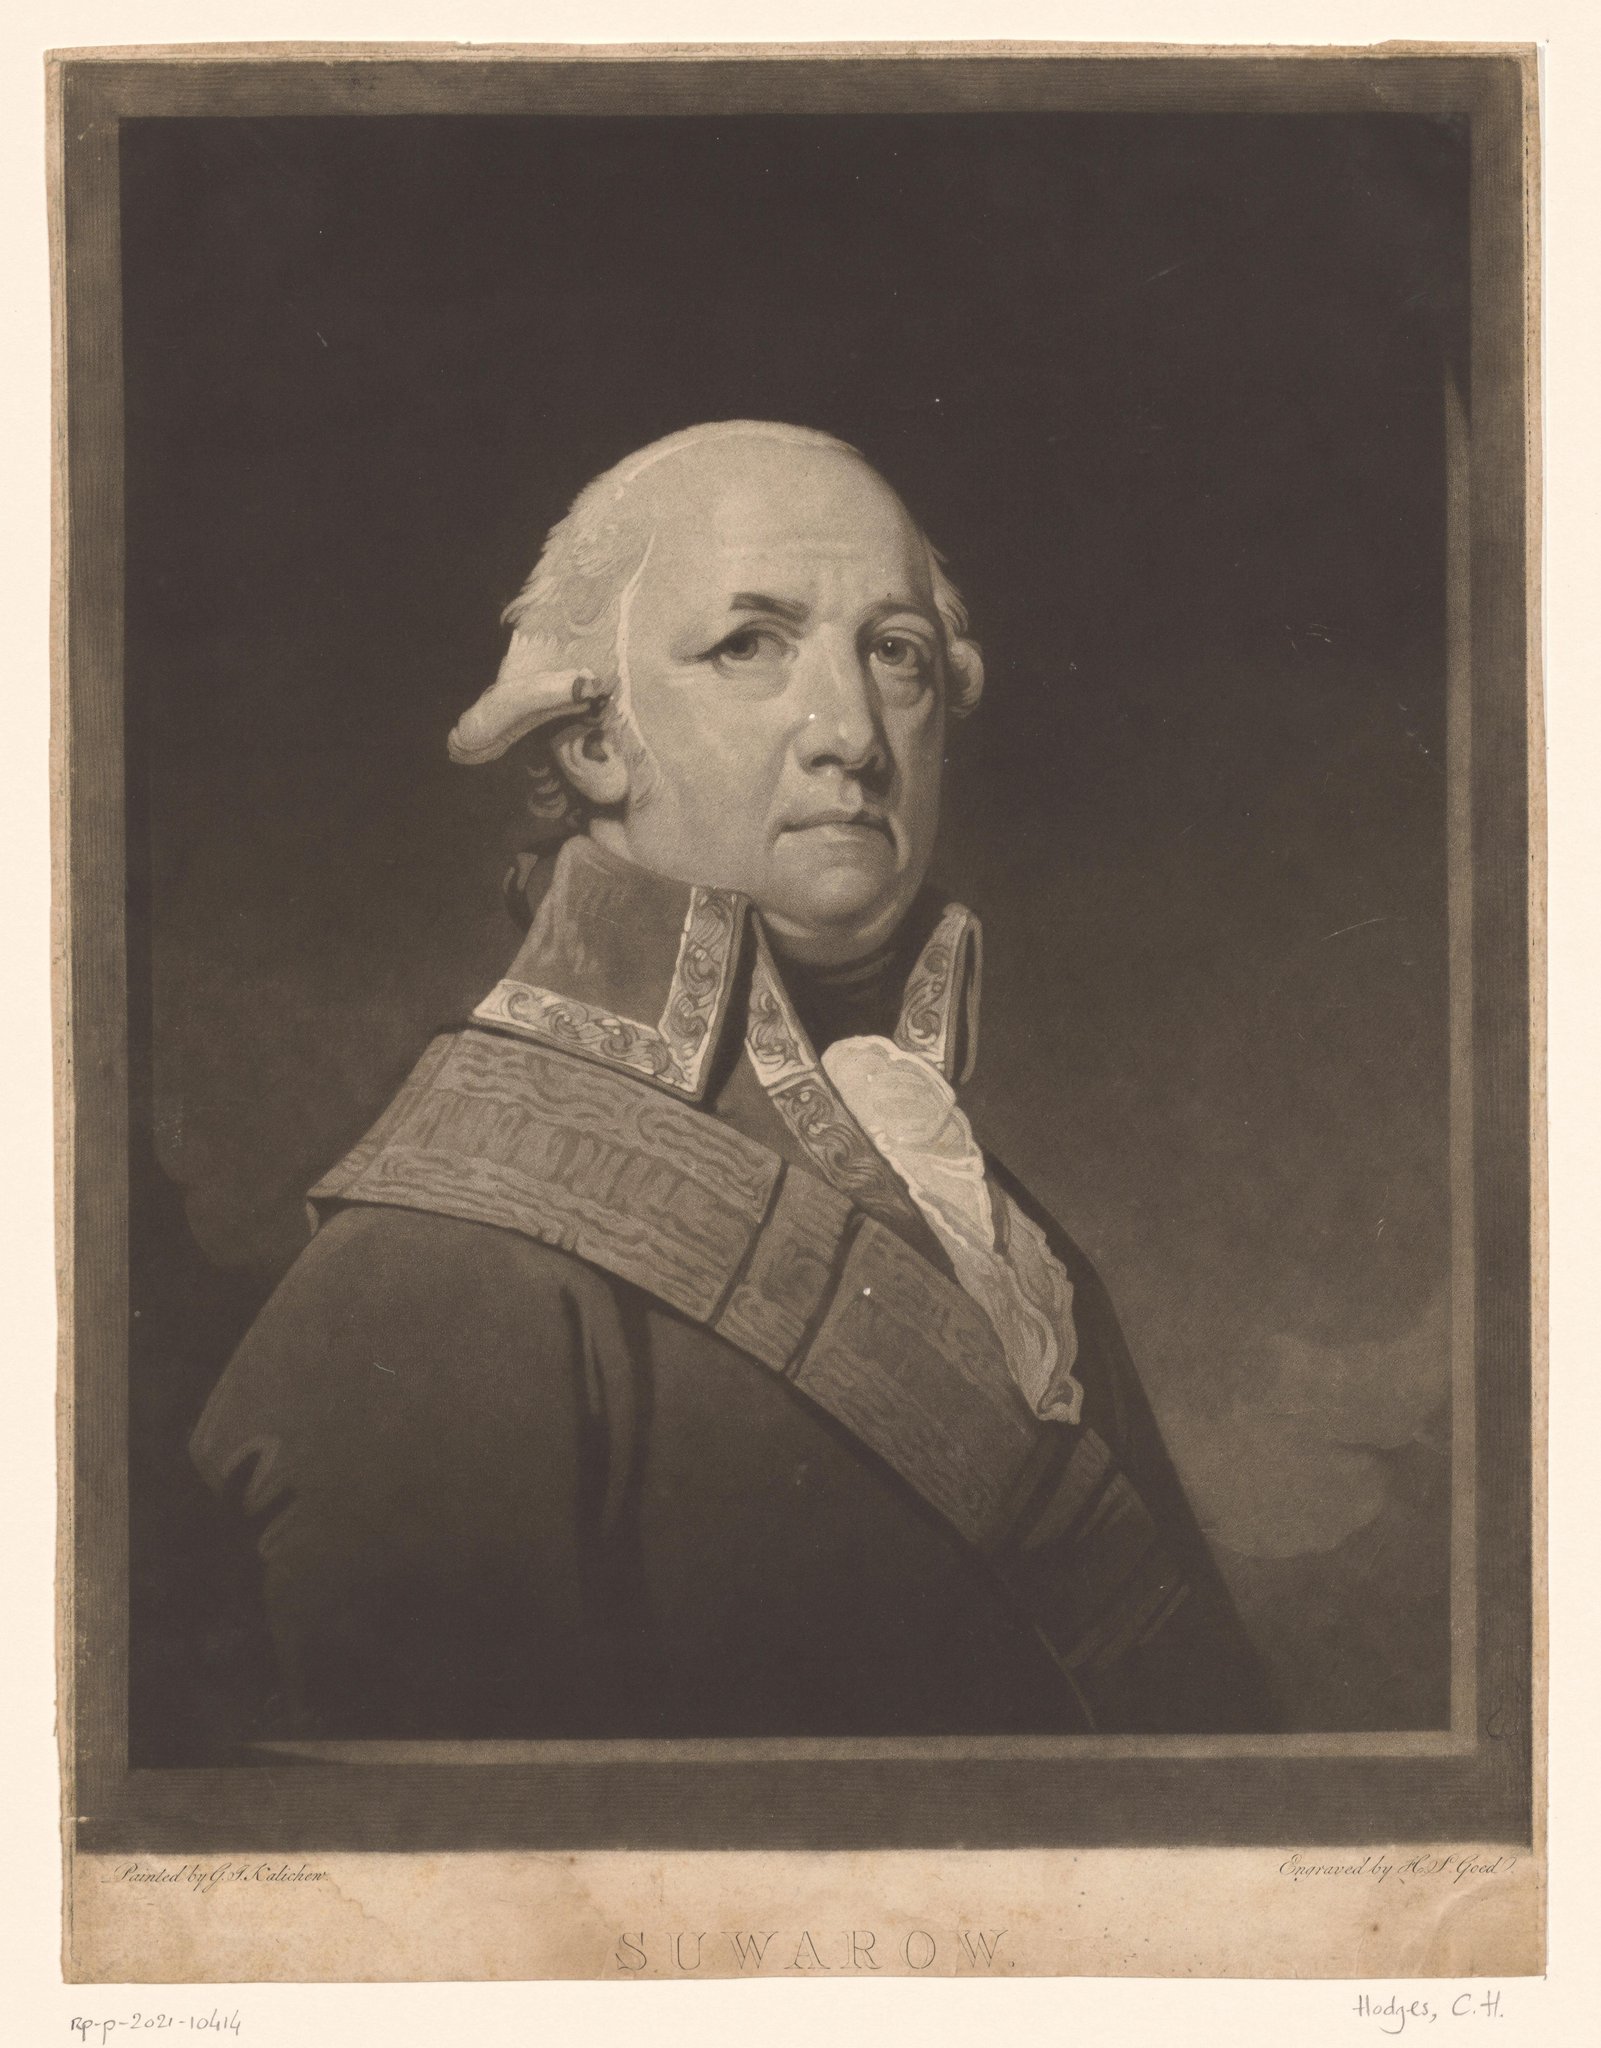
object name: print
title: Portret van een onbekende man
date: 1799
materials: paper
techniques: engraving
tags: adult man, historical persons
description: De geportretteerde is voorheen geïdentificeerd als Alexander Suvarov.